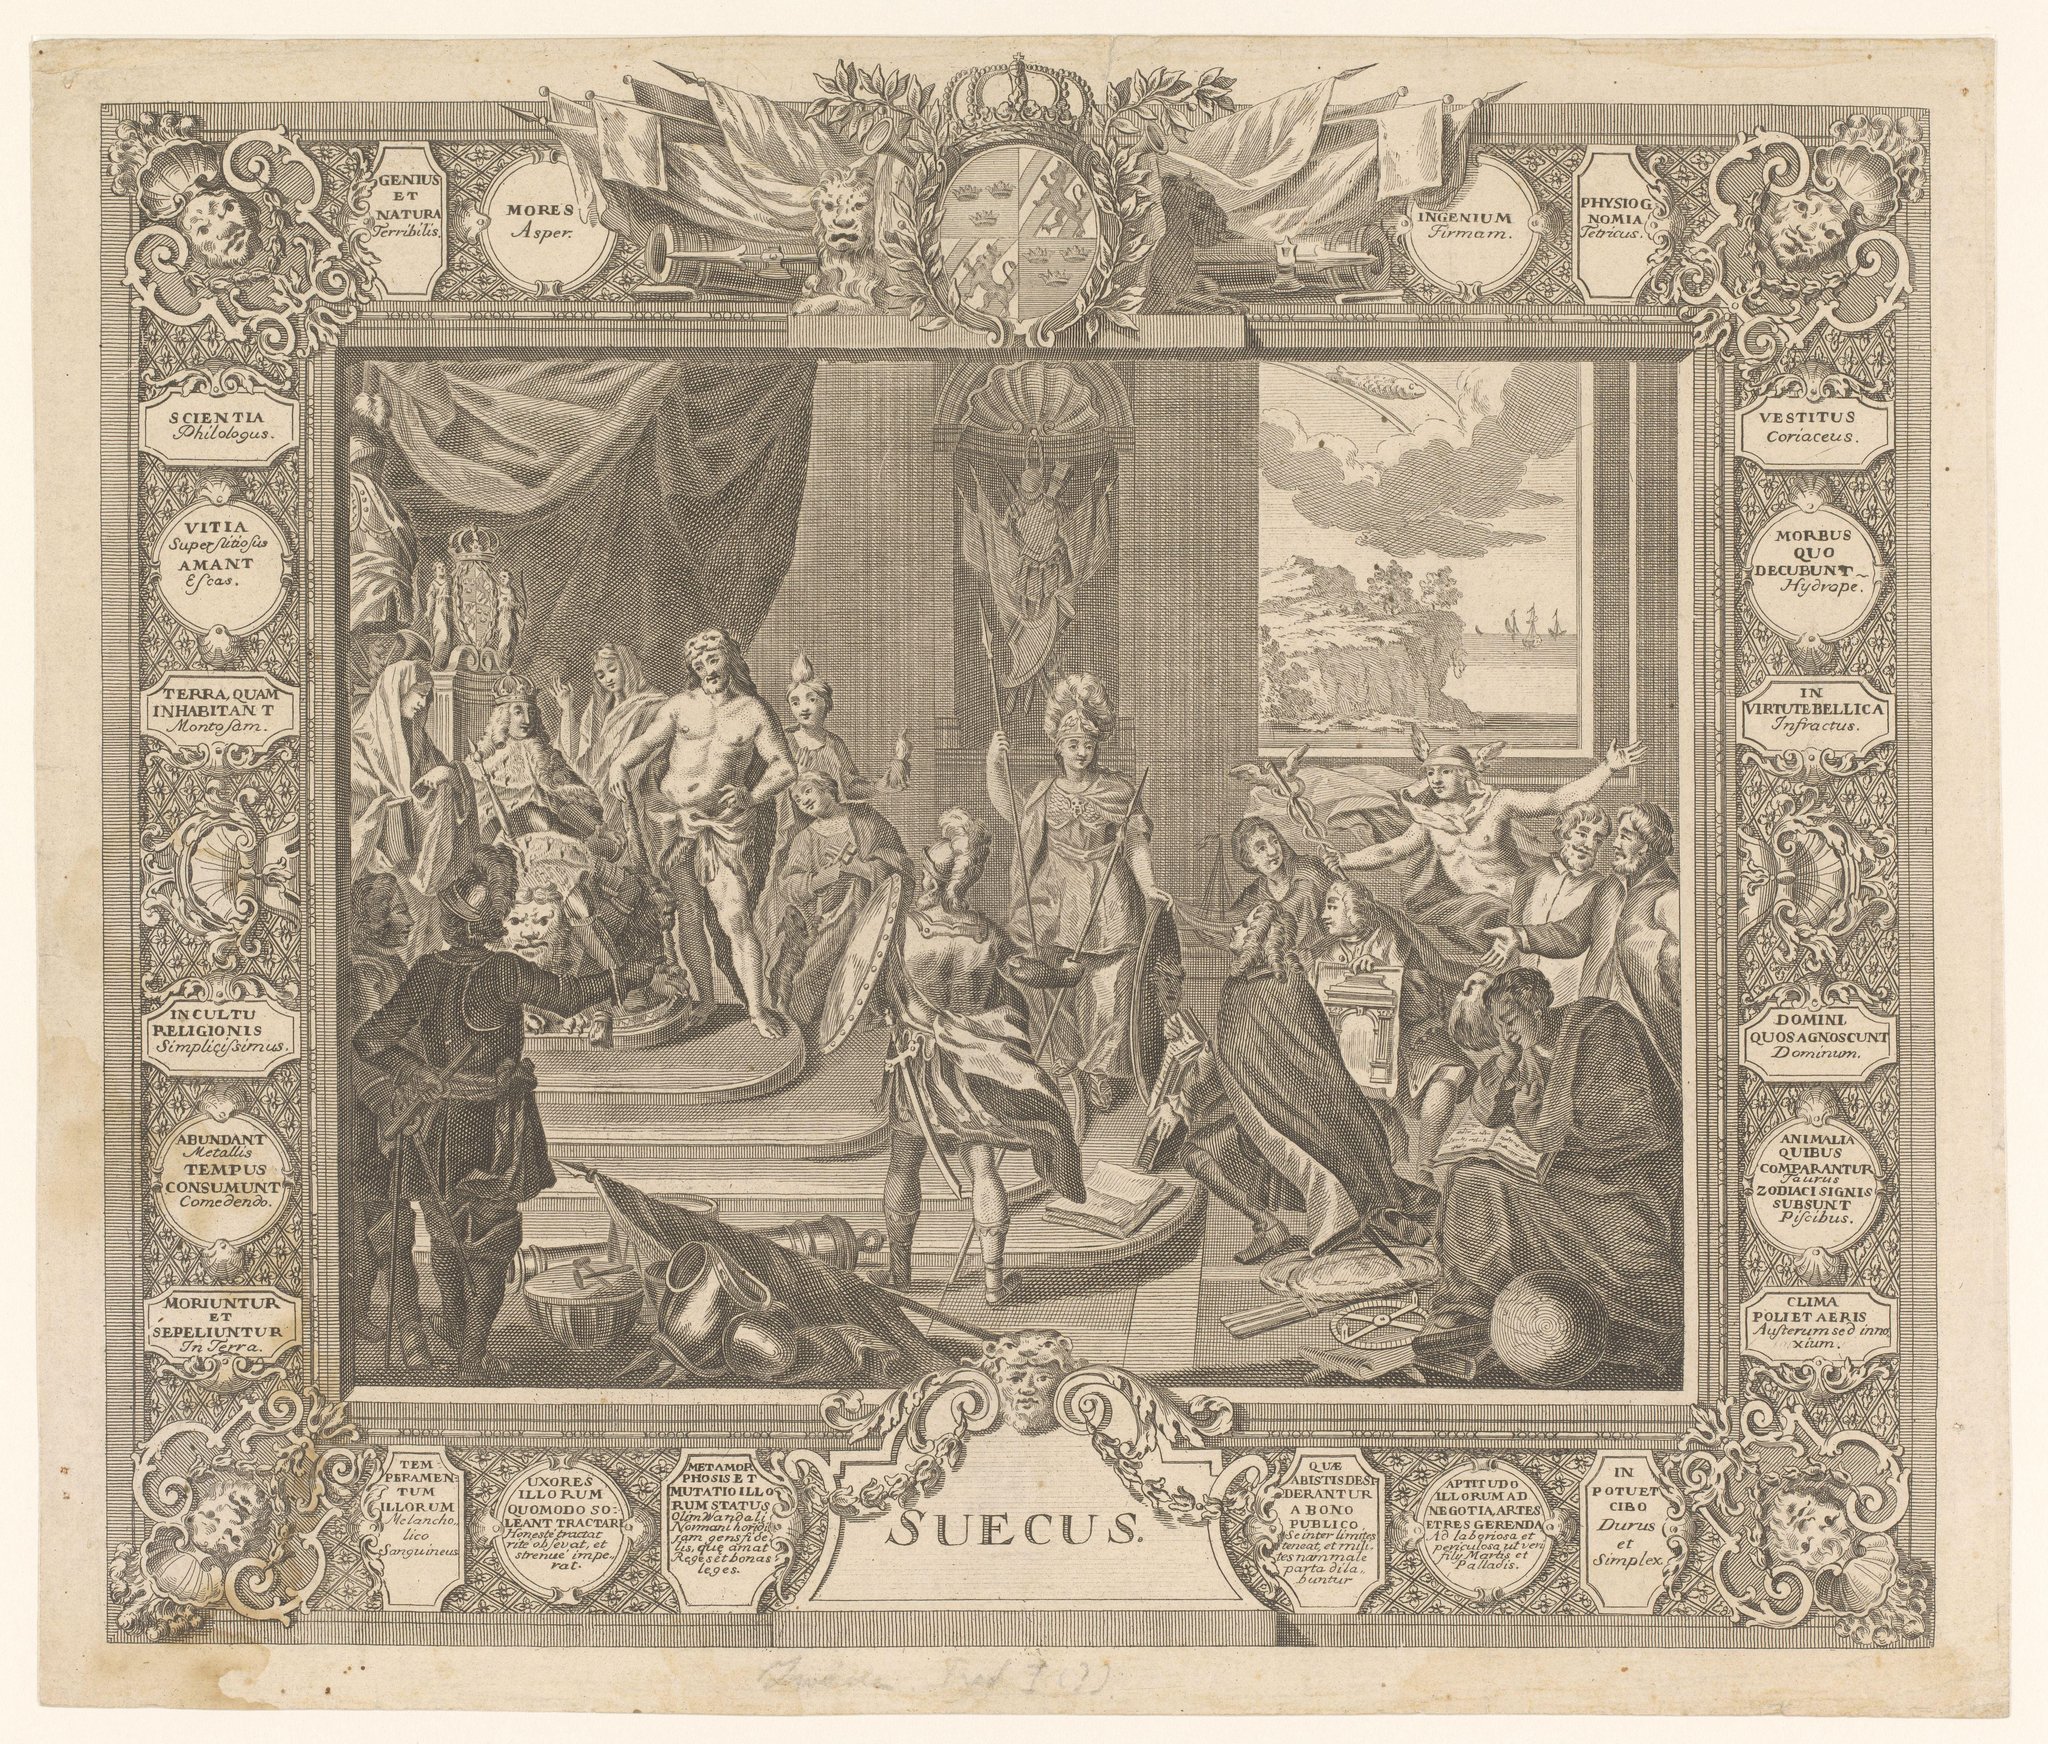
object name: print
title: Allegorie op Zweden of het koningschap van Frederik I van Zweden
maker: Anonymous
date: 1720-1751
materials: paper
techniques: etching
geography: sweden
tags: frederik i (koning van zweden), (story of) hercules (heracles), (story of) minerva (pallas, athena), (story of) mercury (hermes), coat of arms (as symbol of the state, etc.) (+ nation; national), armour, historical persons, architectural design or model, king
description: Vermoedelijk een allegorie op Zweden en/of koning Frederik I. Rondom zijn troon staan verschillende figuren, waaronder Hercules, een gesluierde figuur met boek, een vrouw met een sleutel en een vrouw met vlammend haar en een vlammend hart in haar hand. Verder van de troon staan Minerva en een aantal soldaten. Aan het einde van de trap knielen drie figuren die een boek, een architecturale tekening en een scheepsmodel presenteren. Achter hen staat Mercurius. Rechtsonder zit een figuur die met zijn elleboog en voet leunt op boeken. Naast hem ligt een globe. Rechtsboven een venster waardoor we een landschap met kliffen zien en een vis die afdaalt naar een wolk. Rondom de voorstelling een decoratieve omlijsting met Latijnse inscripties, mogelijk omschrijvingen van Zweden. Bovenin de omlijsting het wapen van Zweden.